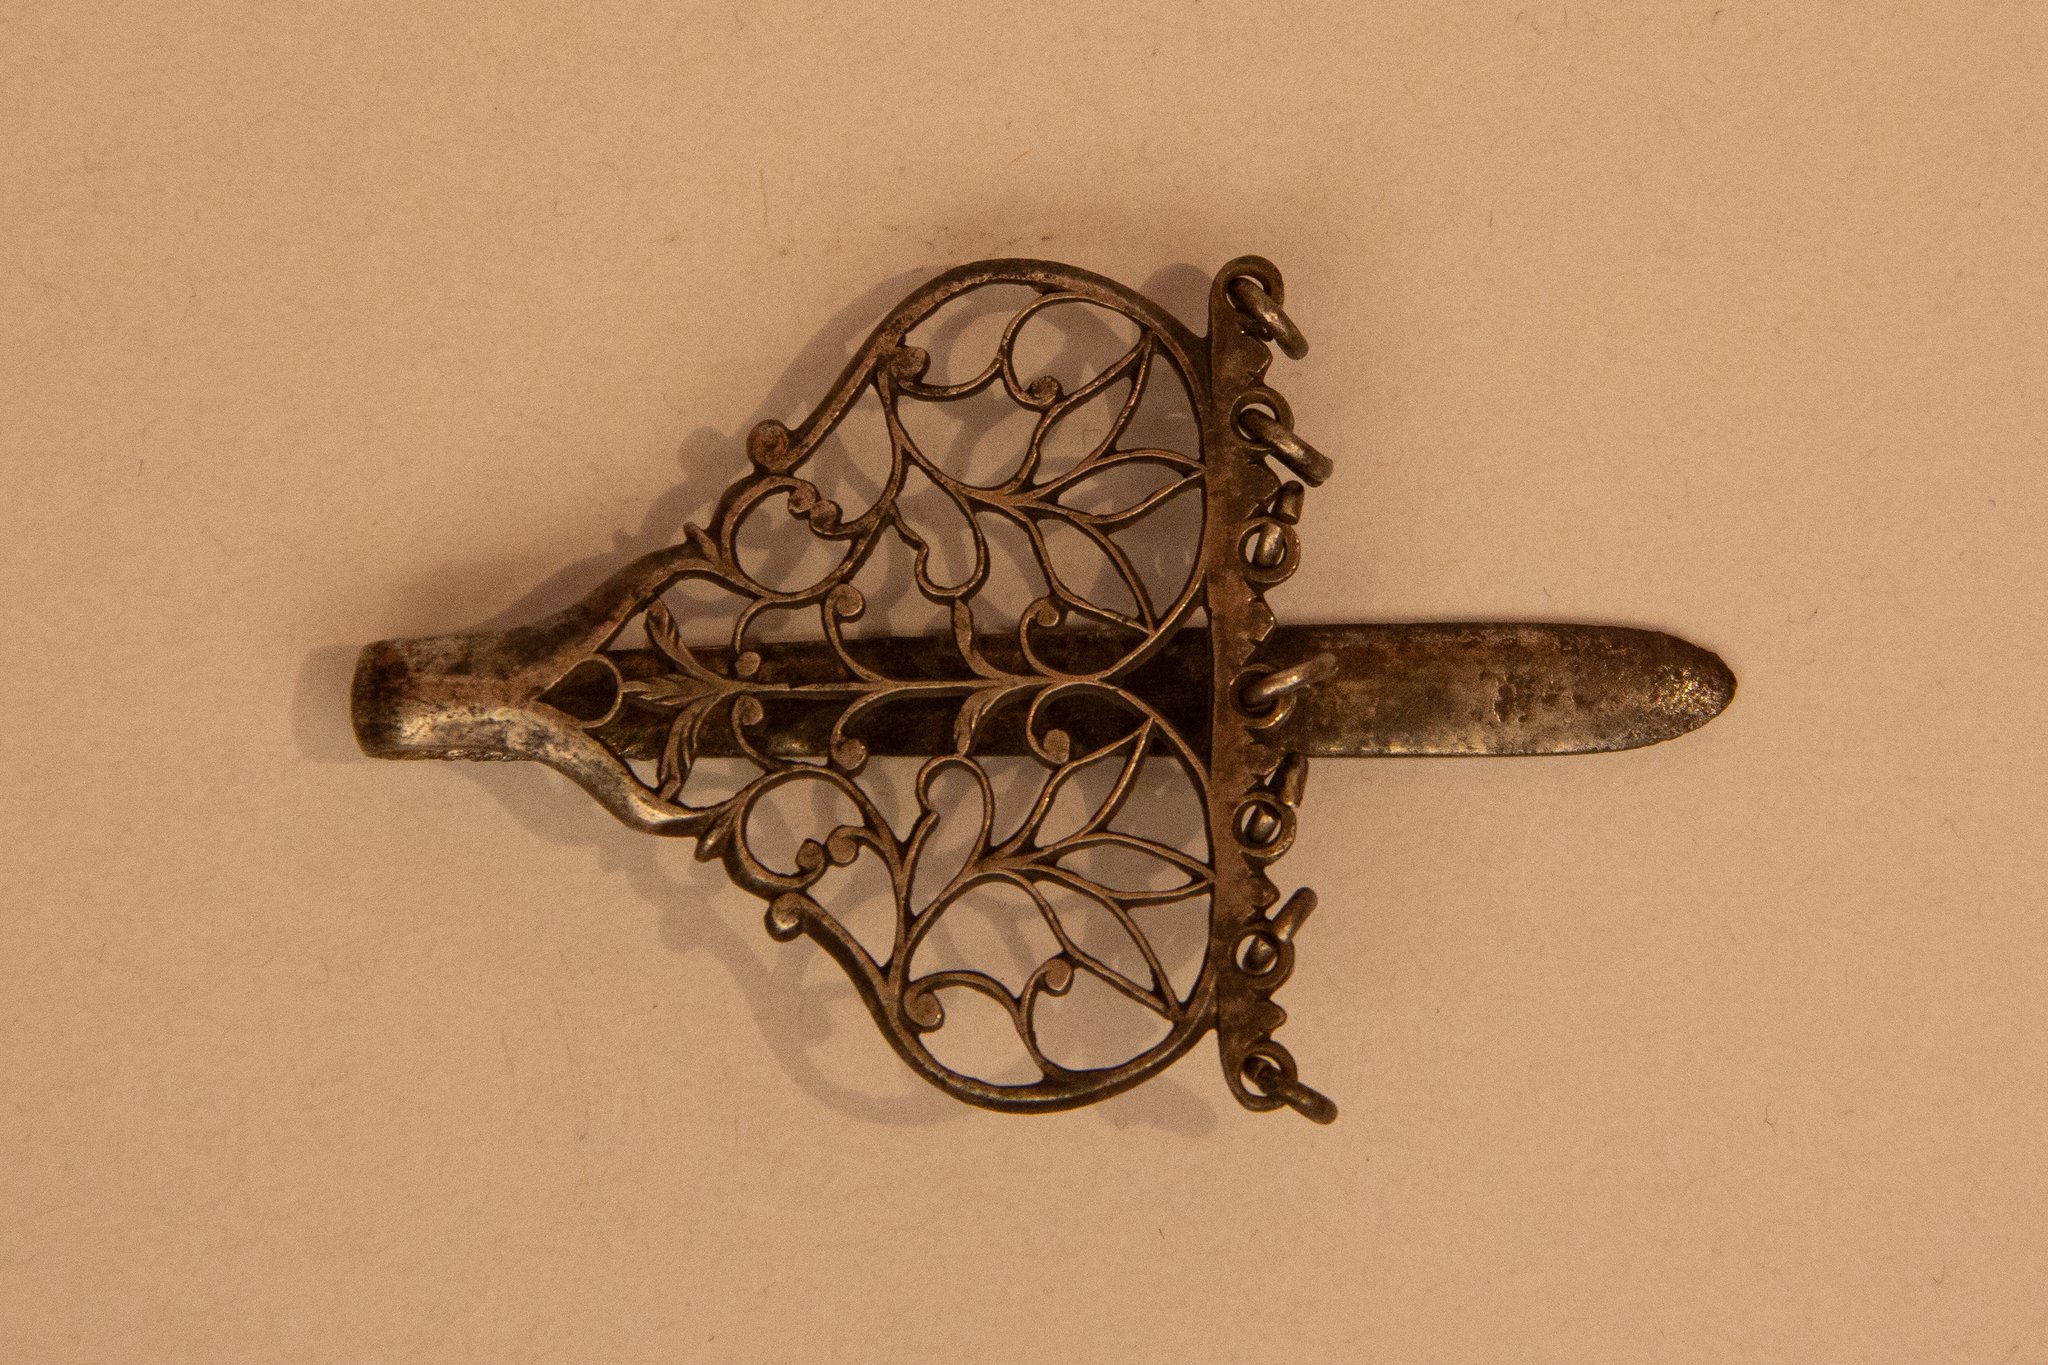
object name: chatelaine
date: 1801-1900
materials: steel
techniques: cutting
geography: india